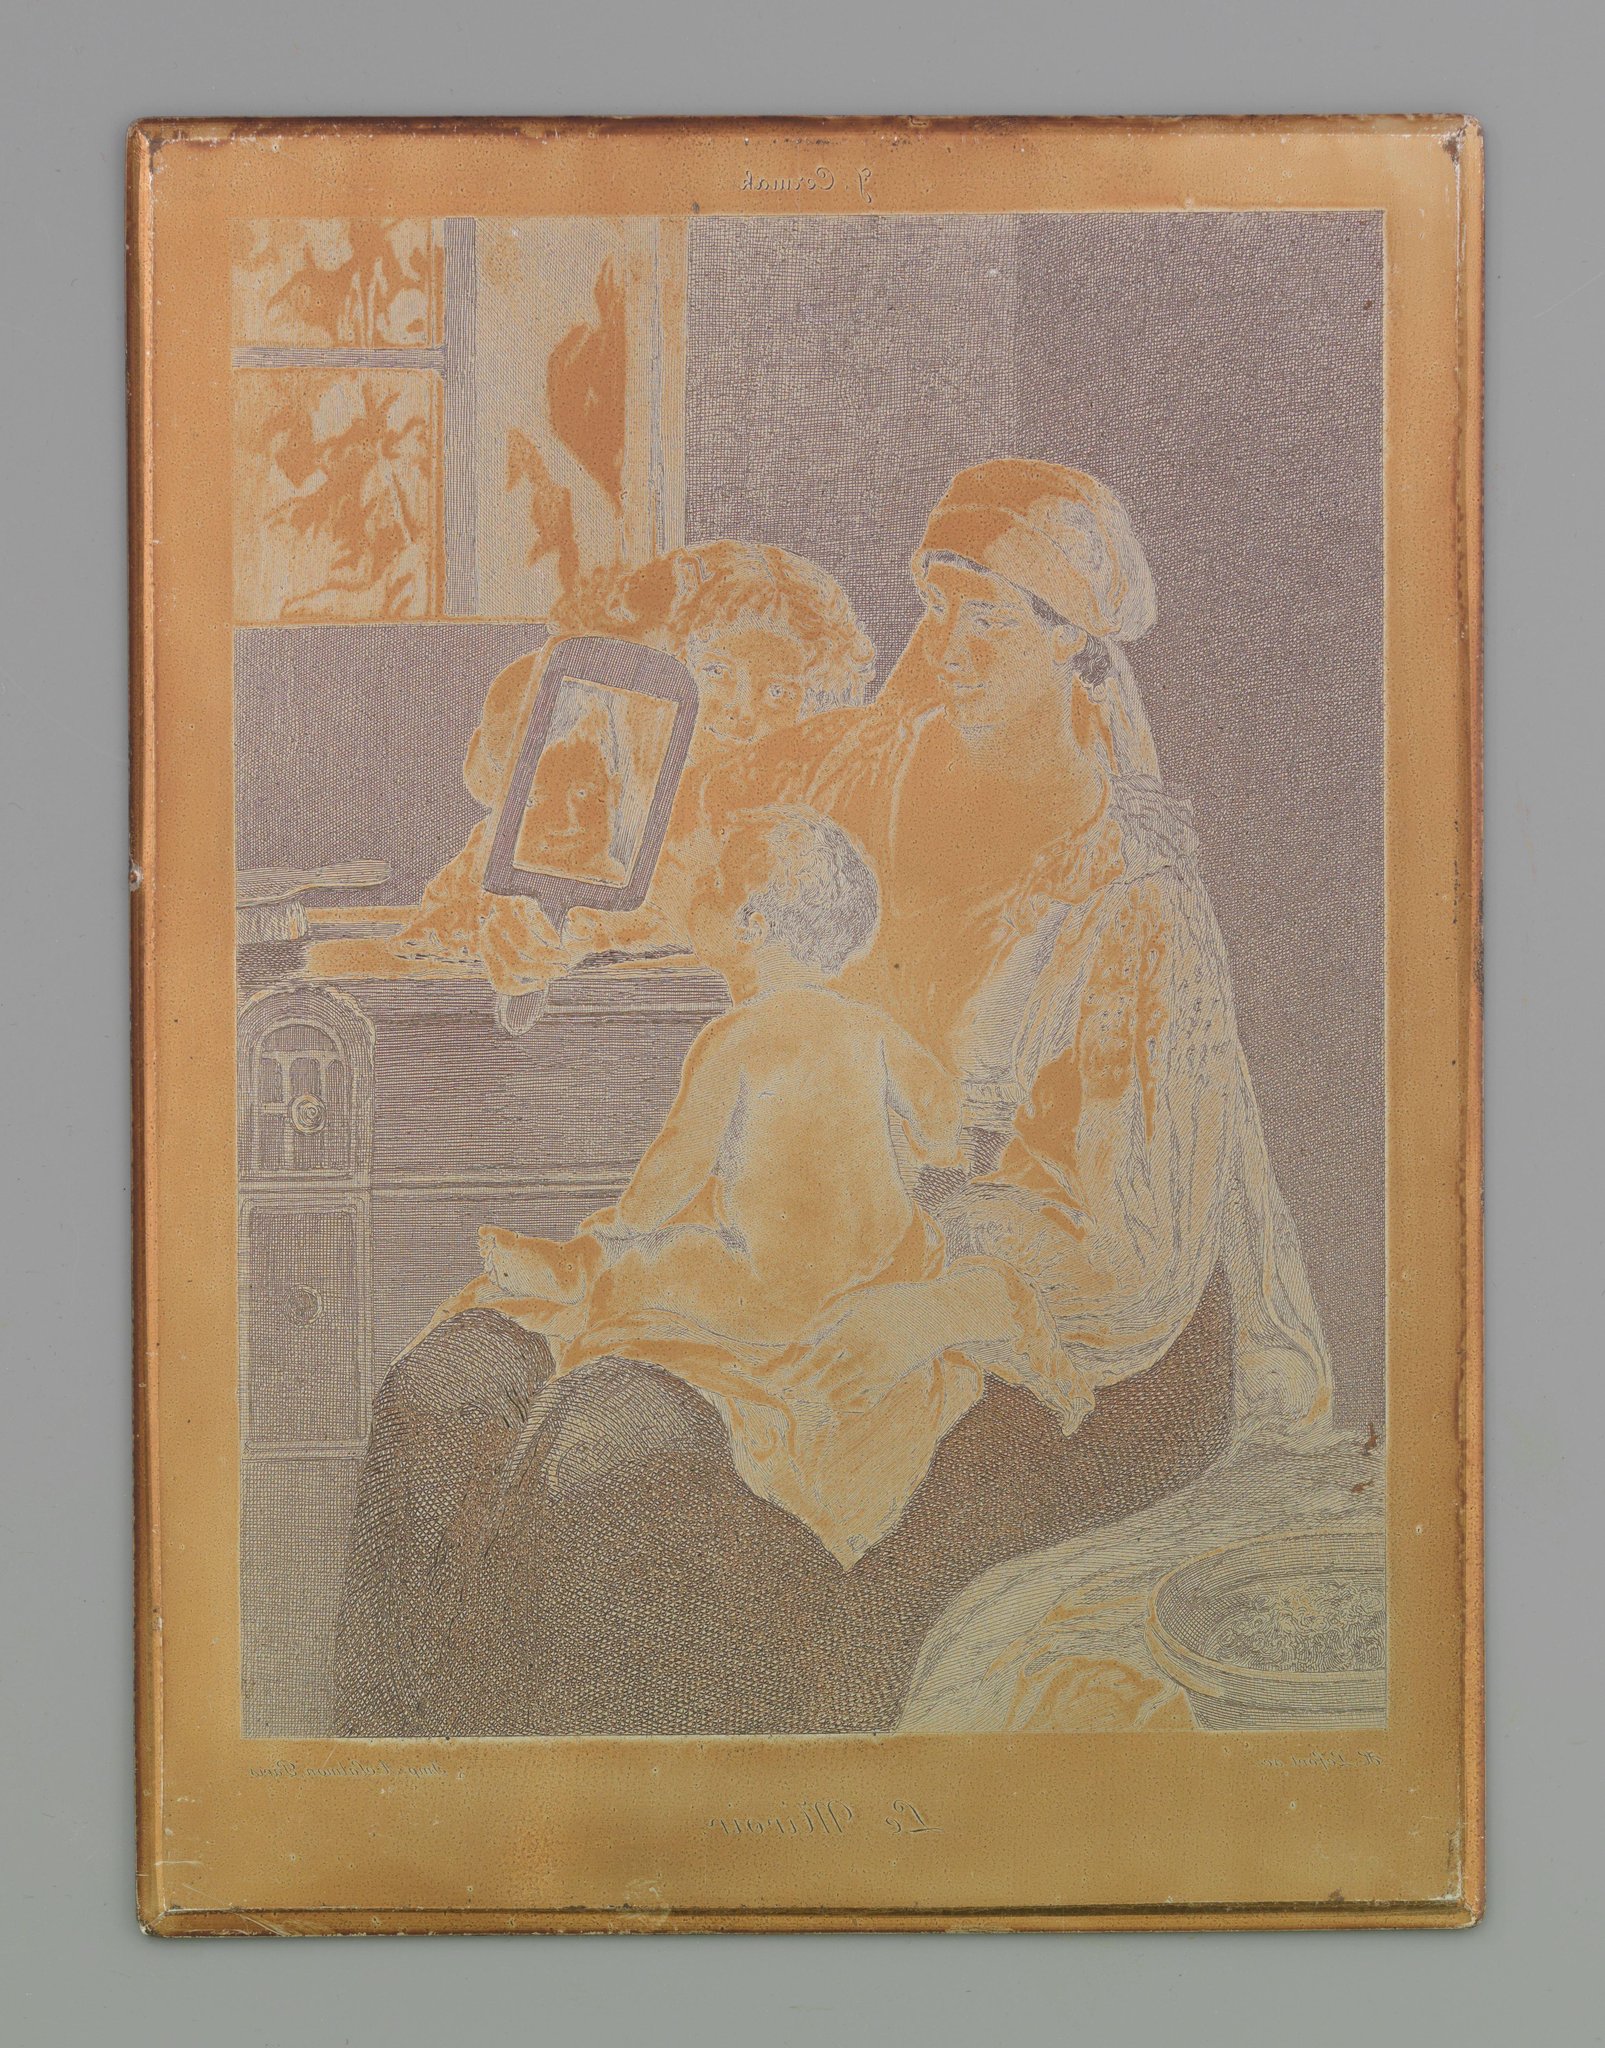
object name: staalplaat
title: Le Miroir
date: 1862-1880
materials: steel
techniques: etching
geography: paris